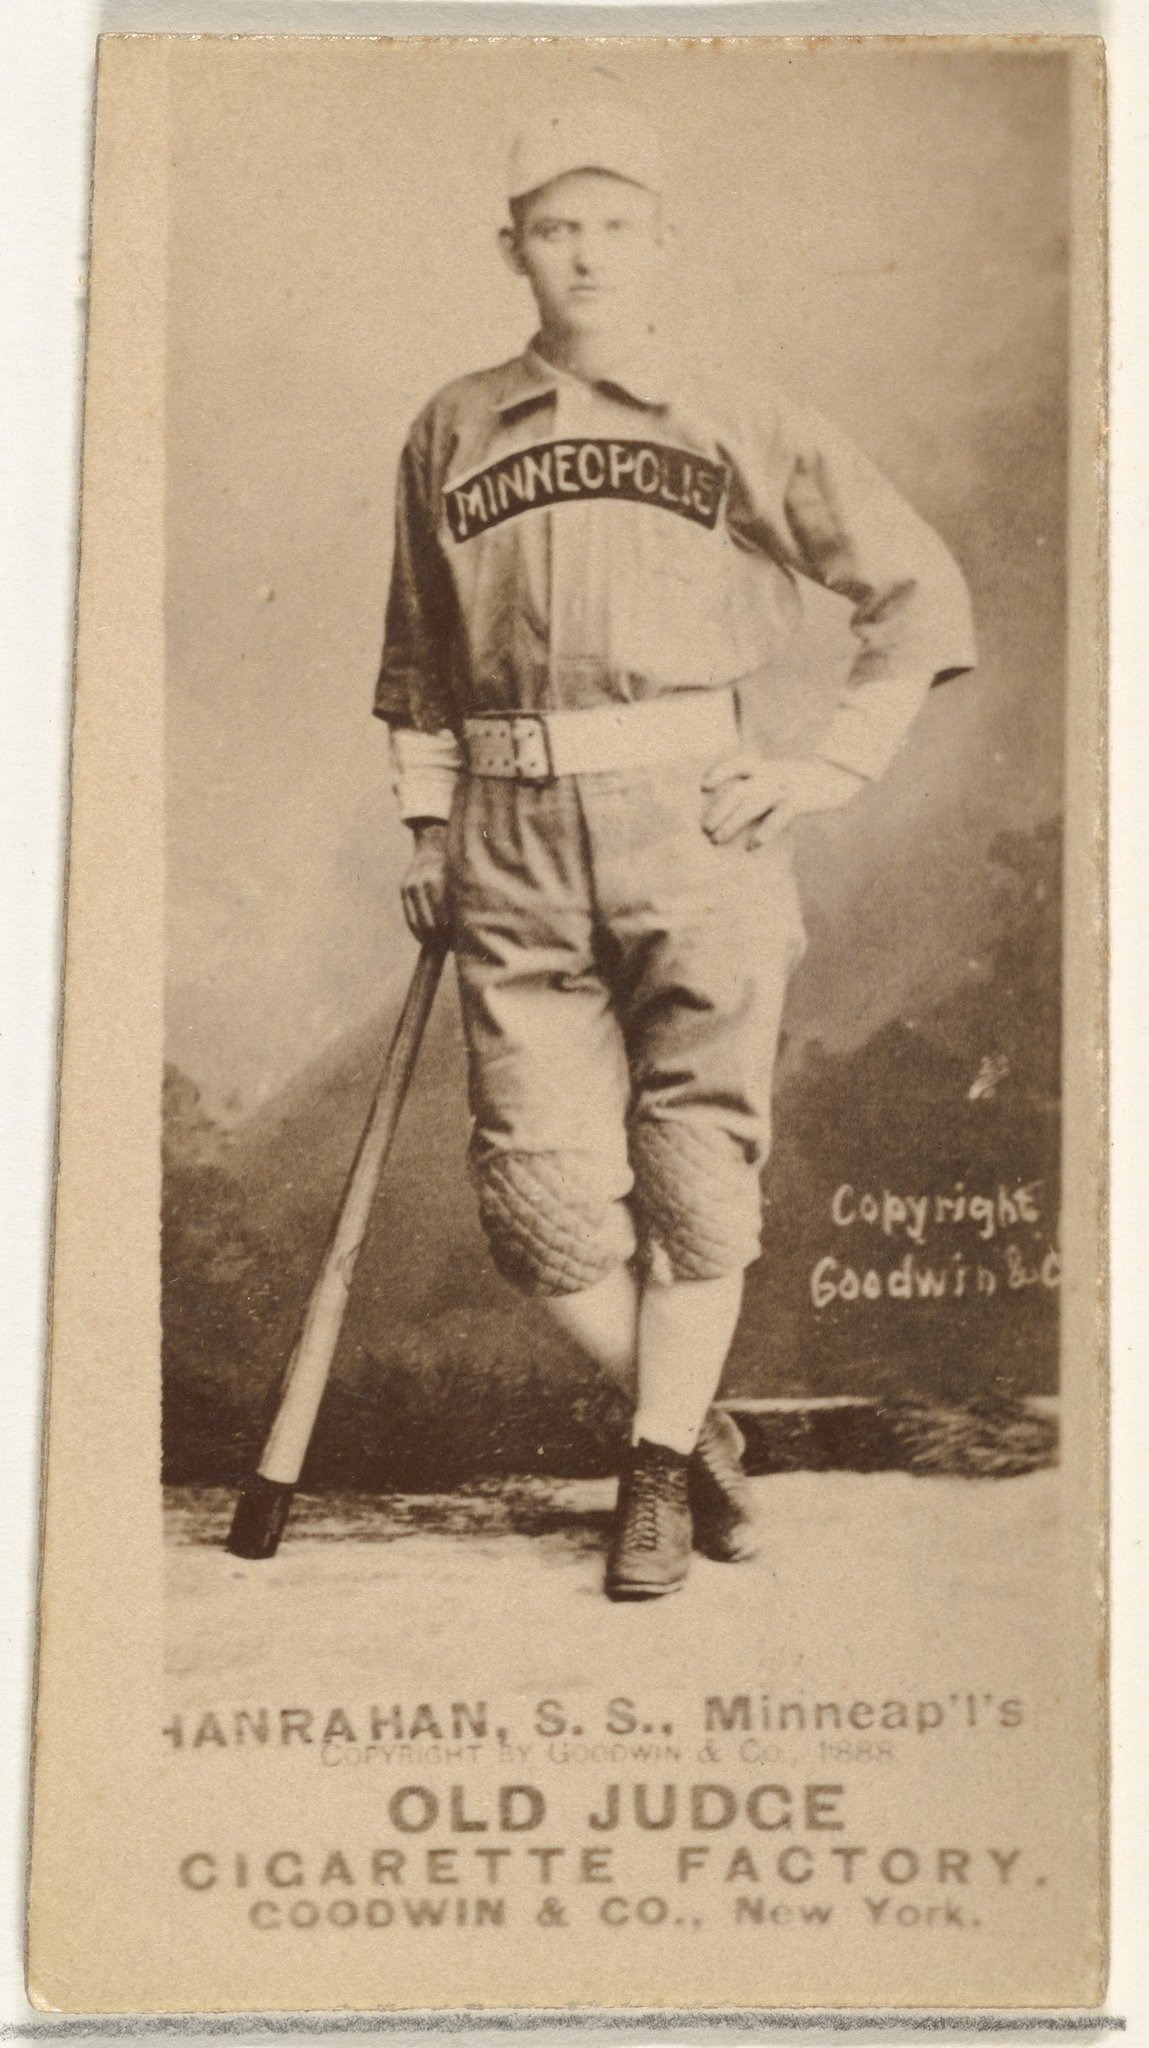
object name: baseball card, photograph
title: William T. "Red" Hanrahan, Shortstop, Minneapolis, from the Old Judge series (N172) for Old Judge Cigarettes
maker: goodwin & company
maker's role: publisher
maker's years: 1850-1950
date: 1888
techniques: albumen silver print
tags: men,portraits,baseball,athletes